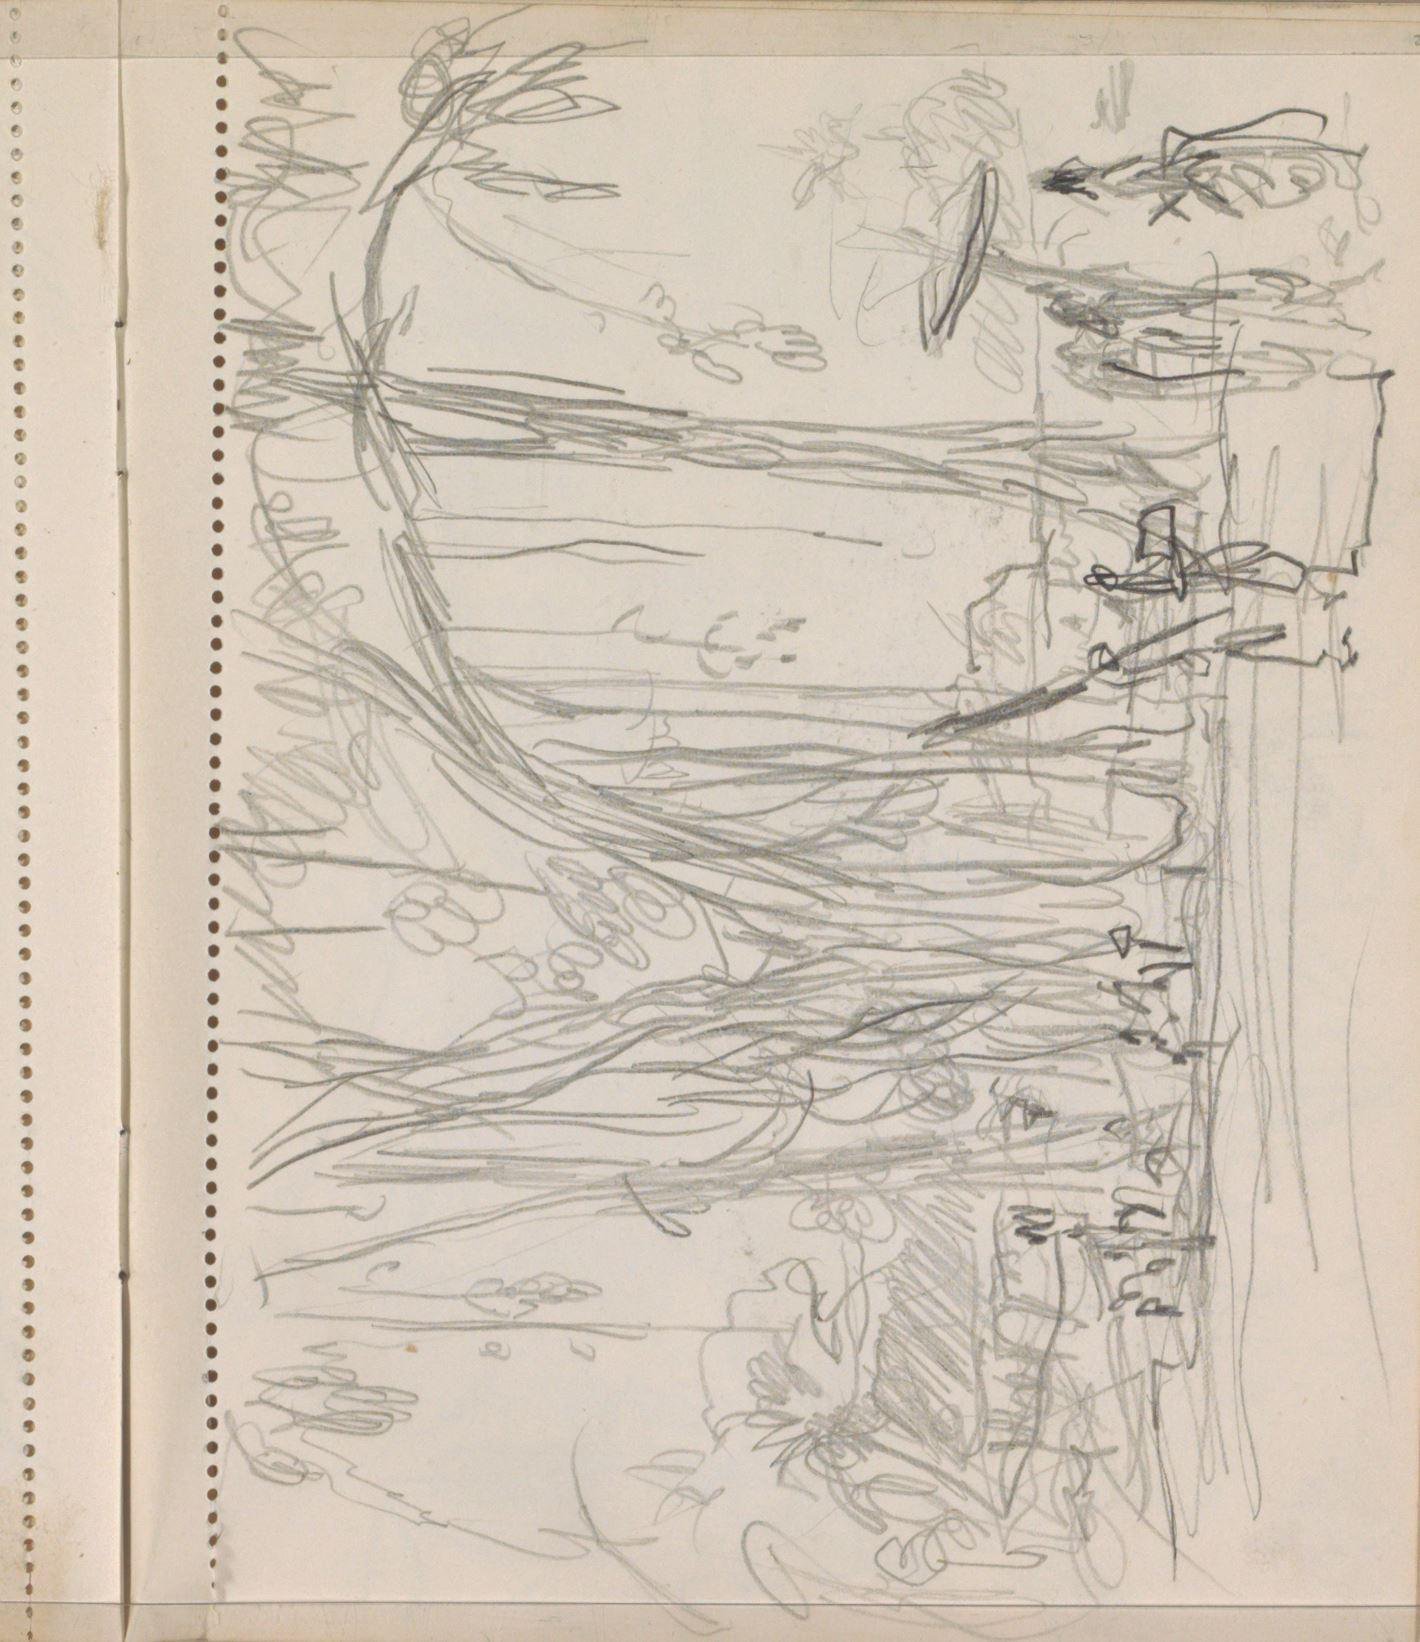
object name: sketchbook leaf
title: Landschap met palmbomen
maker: marius bauer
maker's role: draughtsman, print maker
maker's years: 1867-1932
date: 1925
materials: paper, pencil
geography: indonesia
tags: trees: palm-tree, landscapes (+ landscape with figures, staffage), parasol, sunshade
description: Op de voorgrond enkele figuren met in- en uitgeklapte parasols. Pagina 21 uit een schetsboek met 67 bladen.